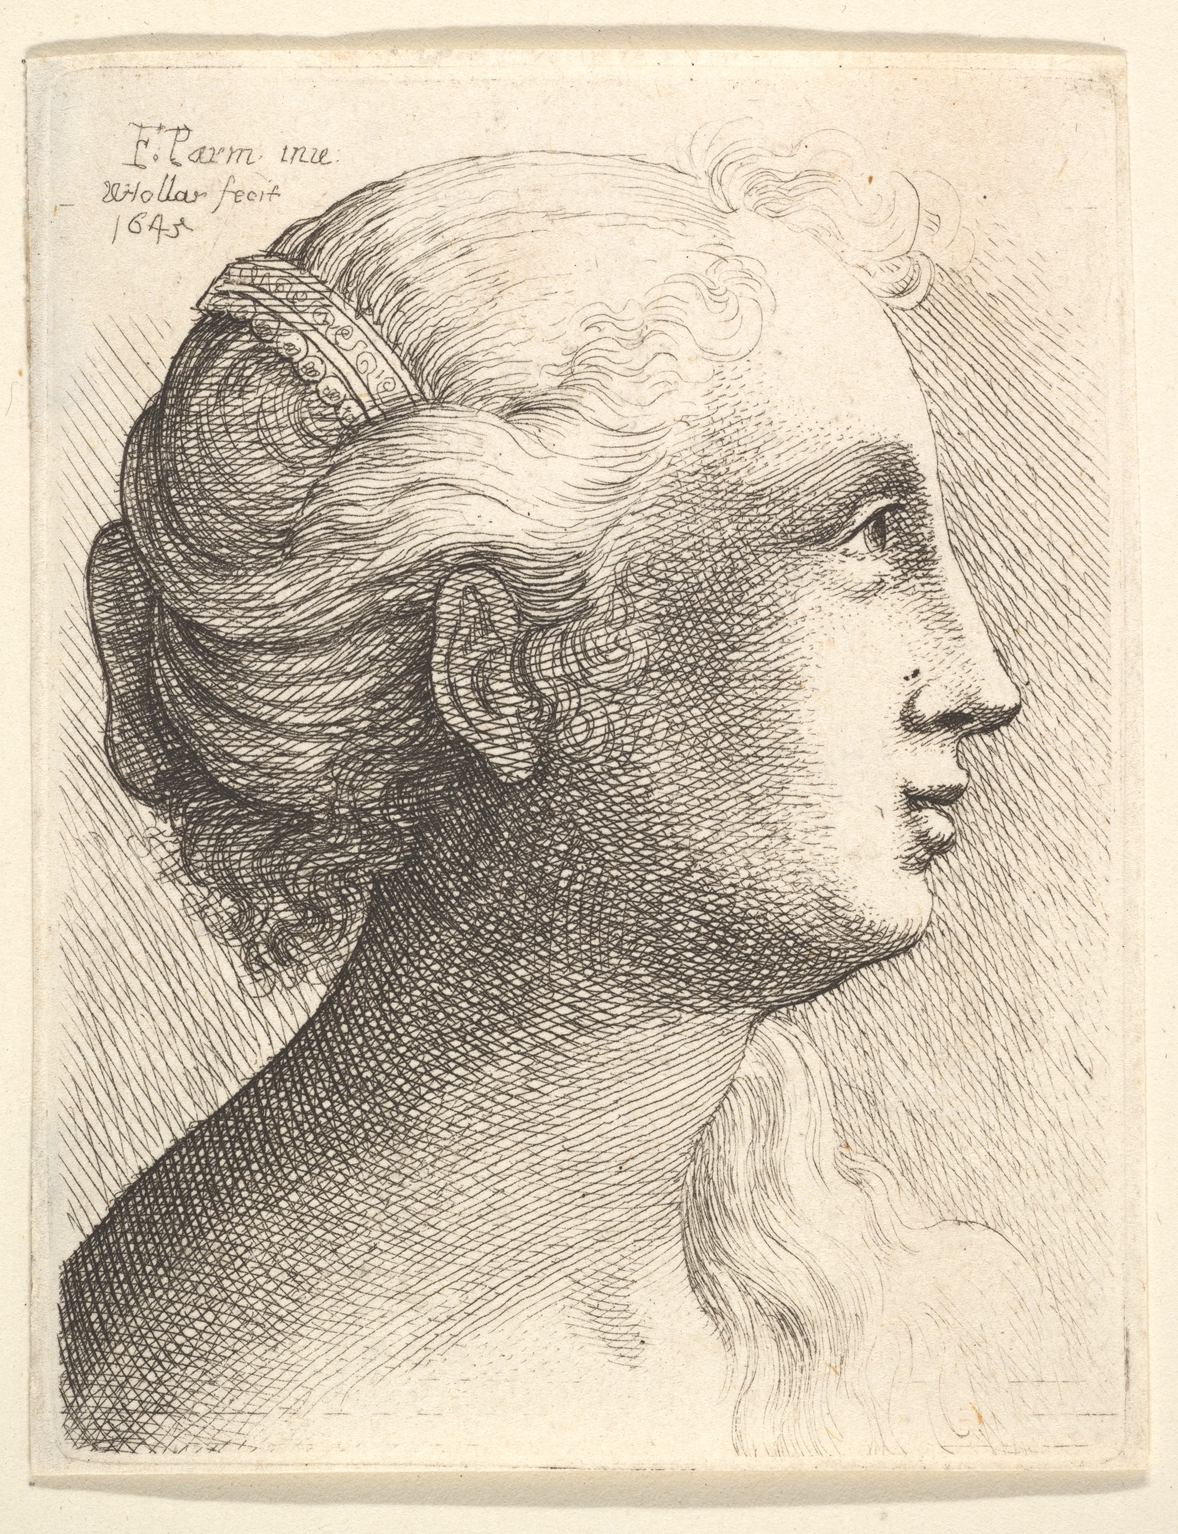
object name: print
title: Head of a young woman in profile to right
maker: wenceslaus hollar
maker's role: artist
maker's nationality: bohemian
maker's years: 1607-1677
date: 1645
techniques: etching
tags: portraits,women